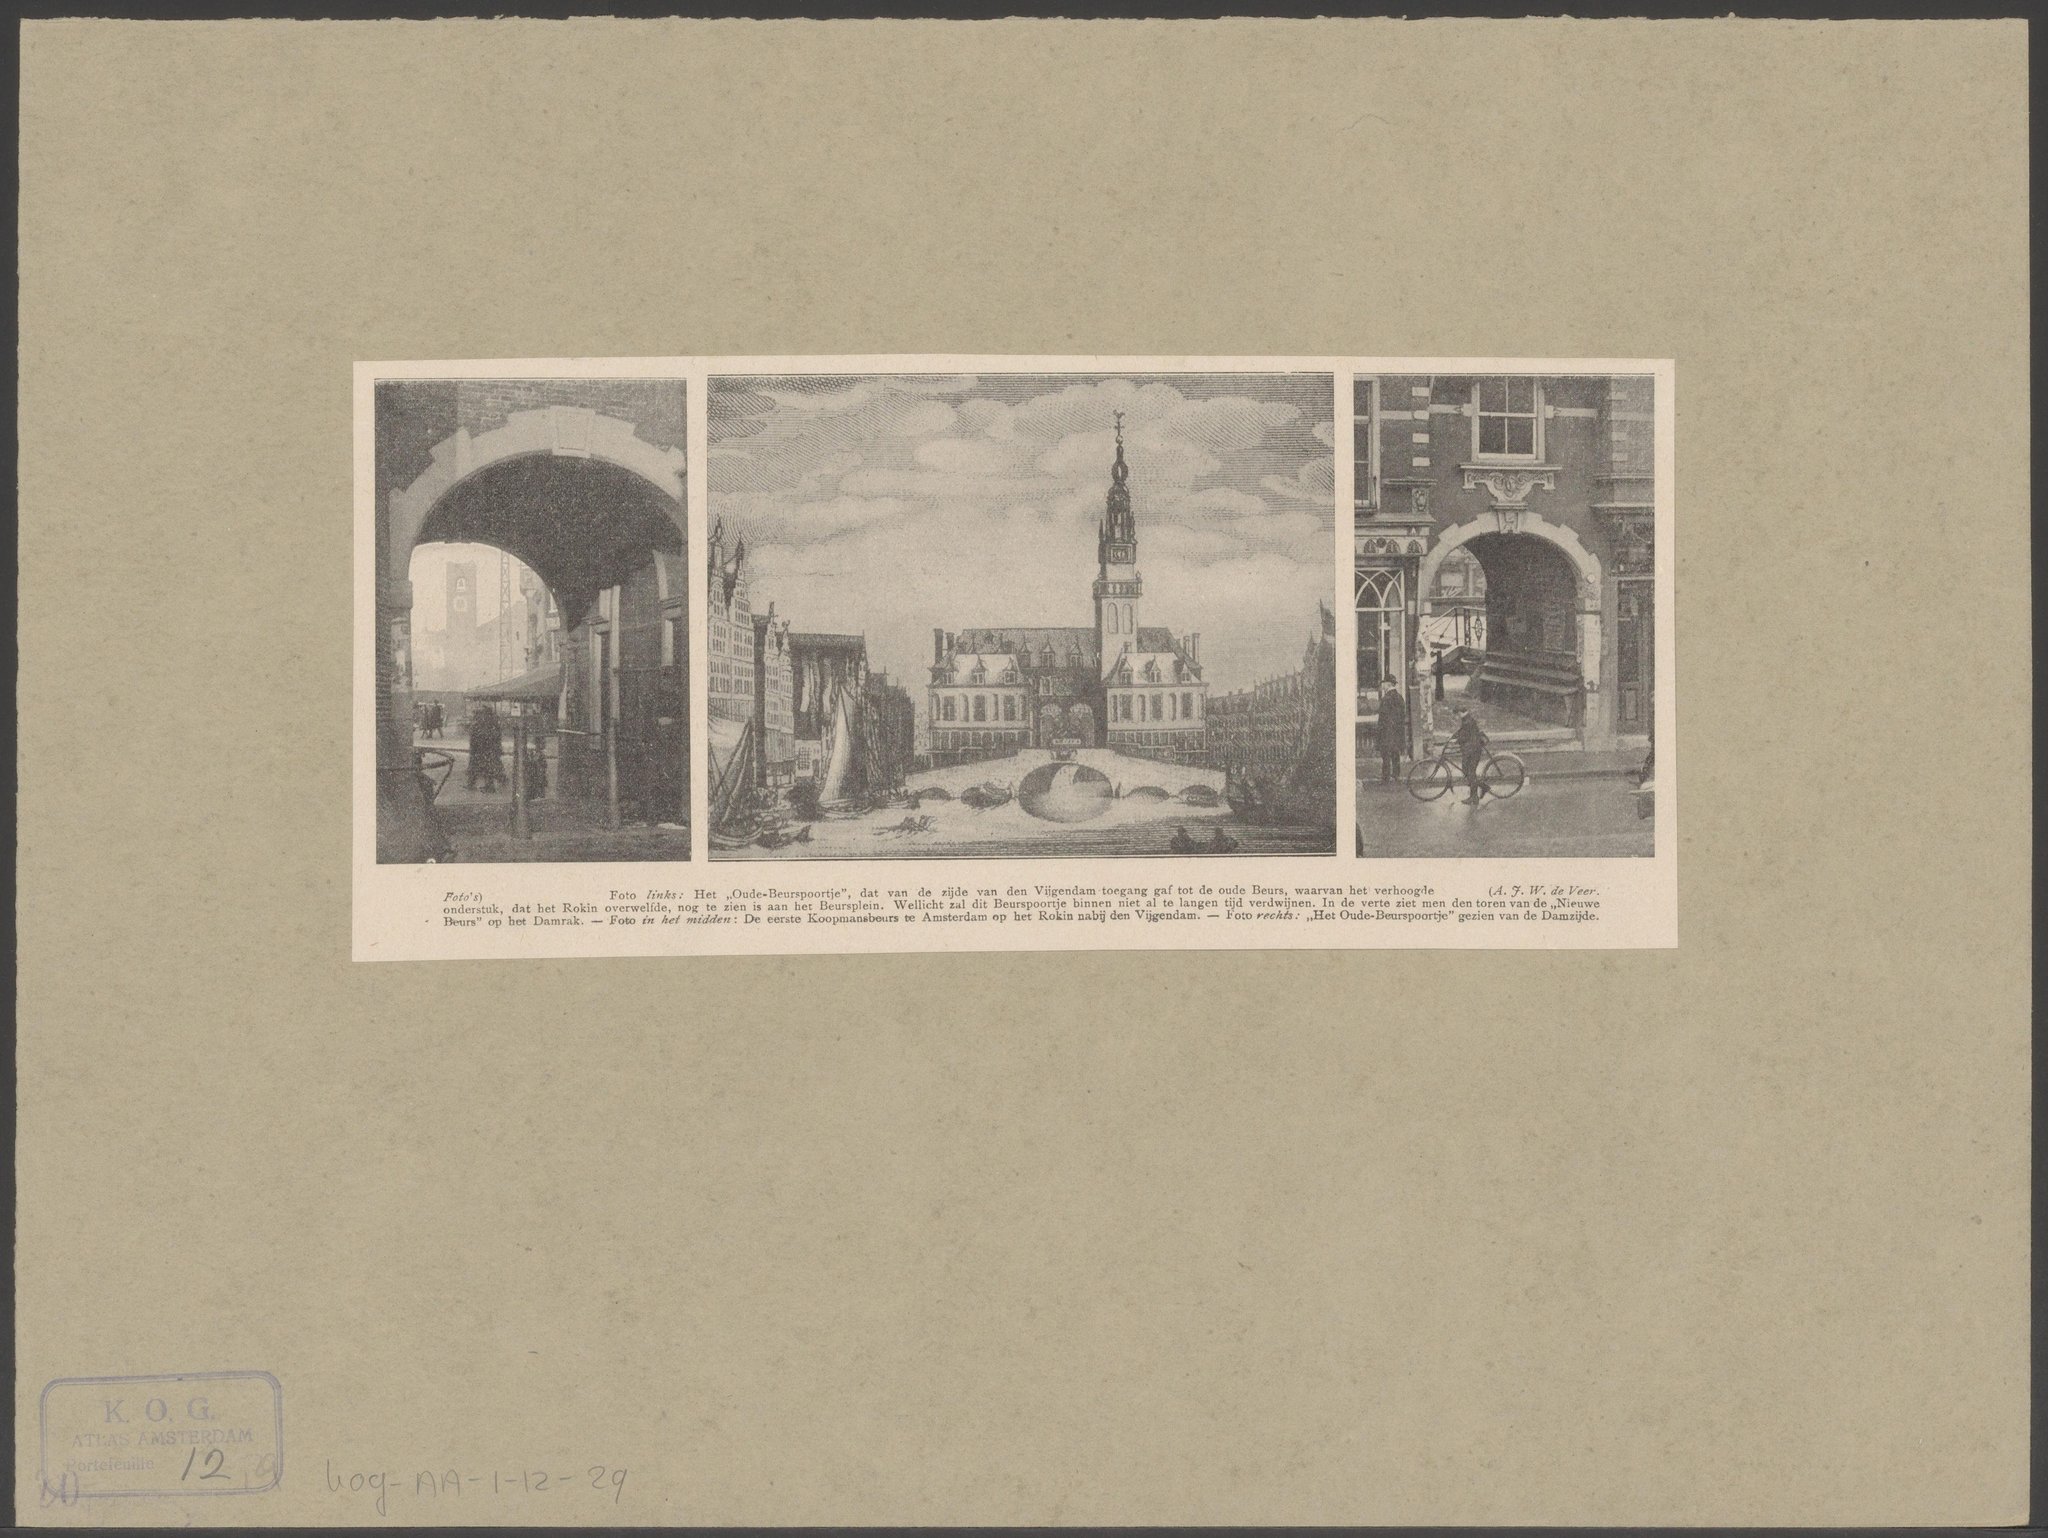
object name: photomechanical print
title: Gezicht op het Beurspoortje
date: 1882-1950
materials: paper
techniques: letterpress printing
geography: amsterdam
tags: square, place, circus, etc., city-view in general; 'veduta', gate, entrance, market-hall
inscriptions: collector's mark: ‘12,29’ Lugt 1641b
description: Onderwerpsrubriek binnen de Atlas Amsterdam: Rokin, Rotterdammersloot, Rozengang, Rozengracht, Rozenstraat, Rusland, Rustenburgerstraat, Ruysdaelkade, Ruysdaelstraat, Ruyterkade (de), Ruyterweg (Admiraal de).